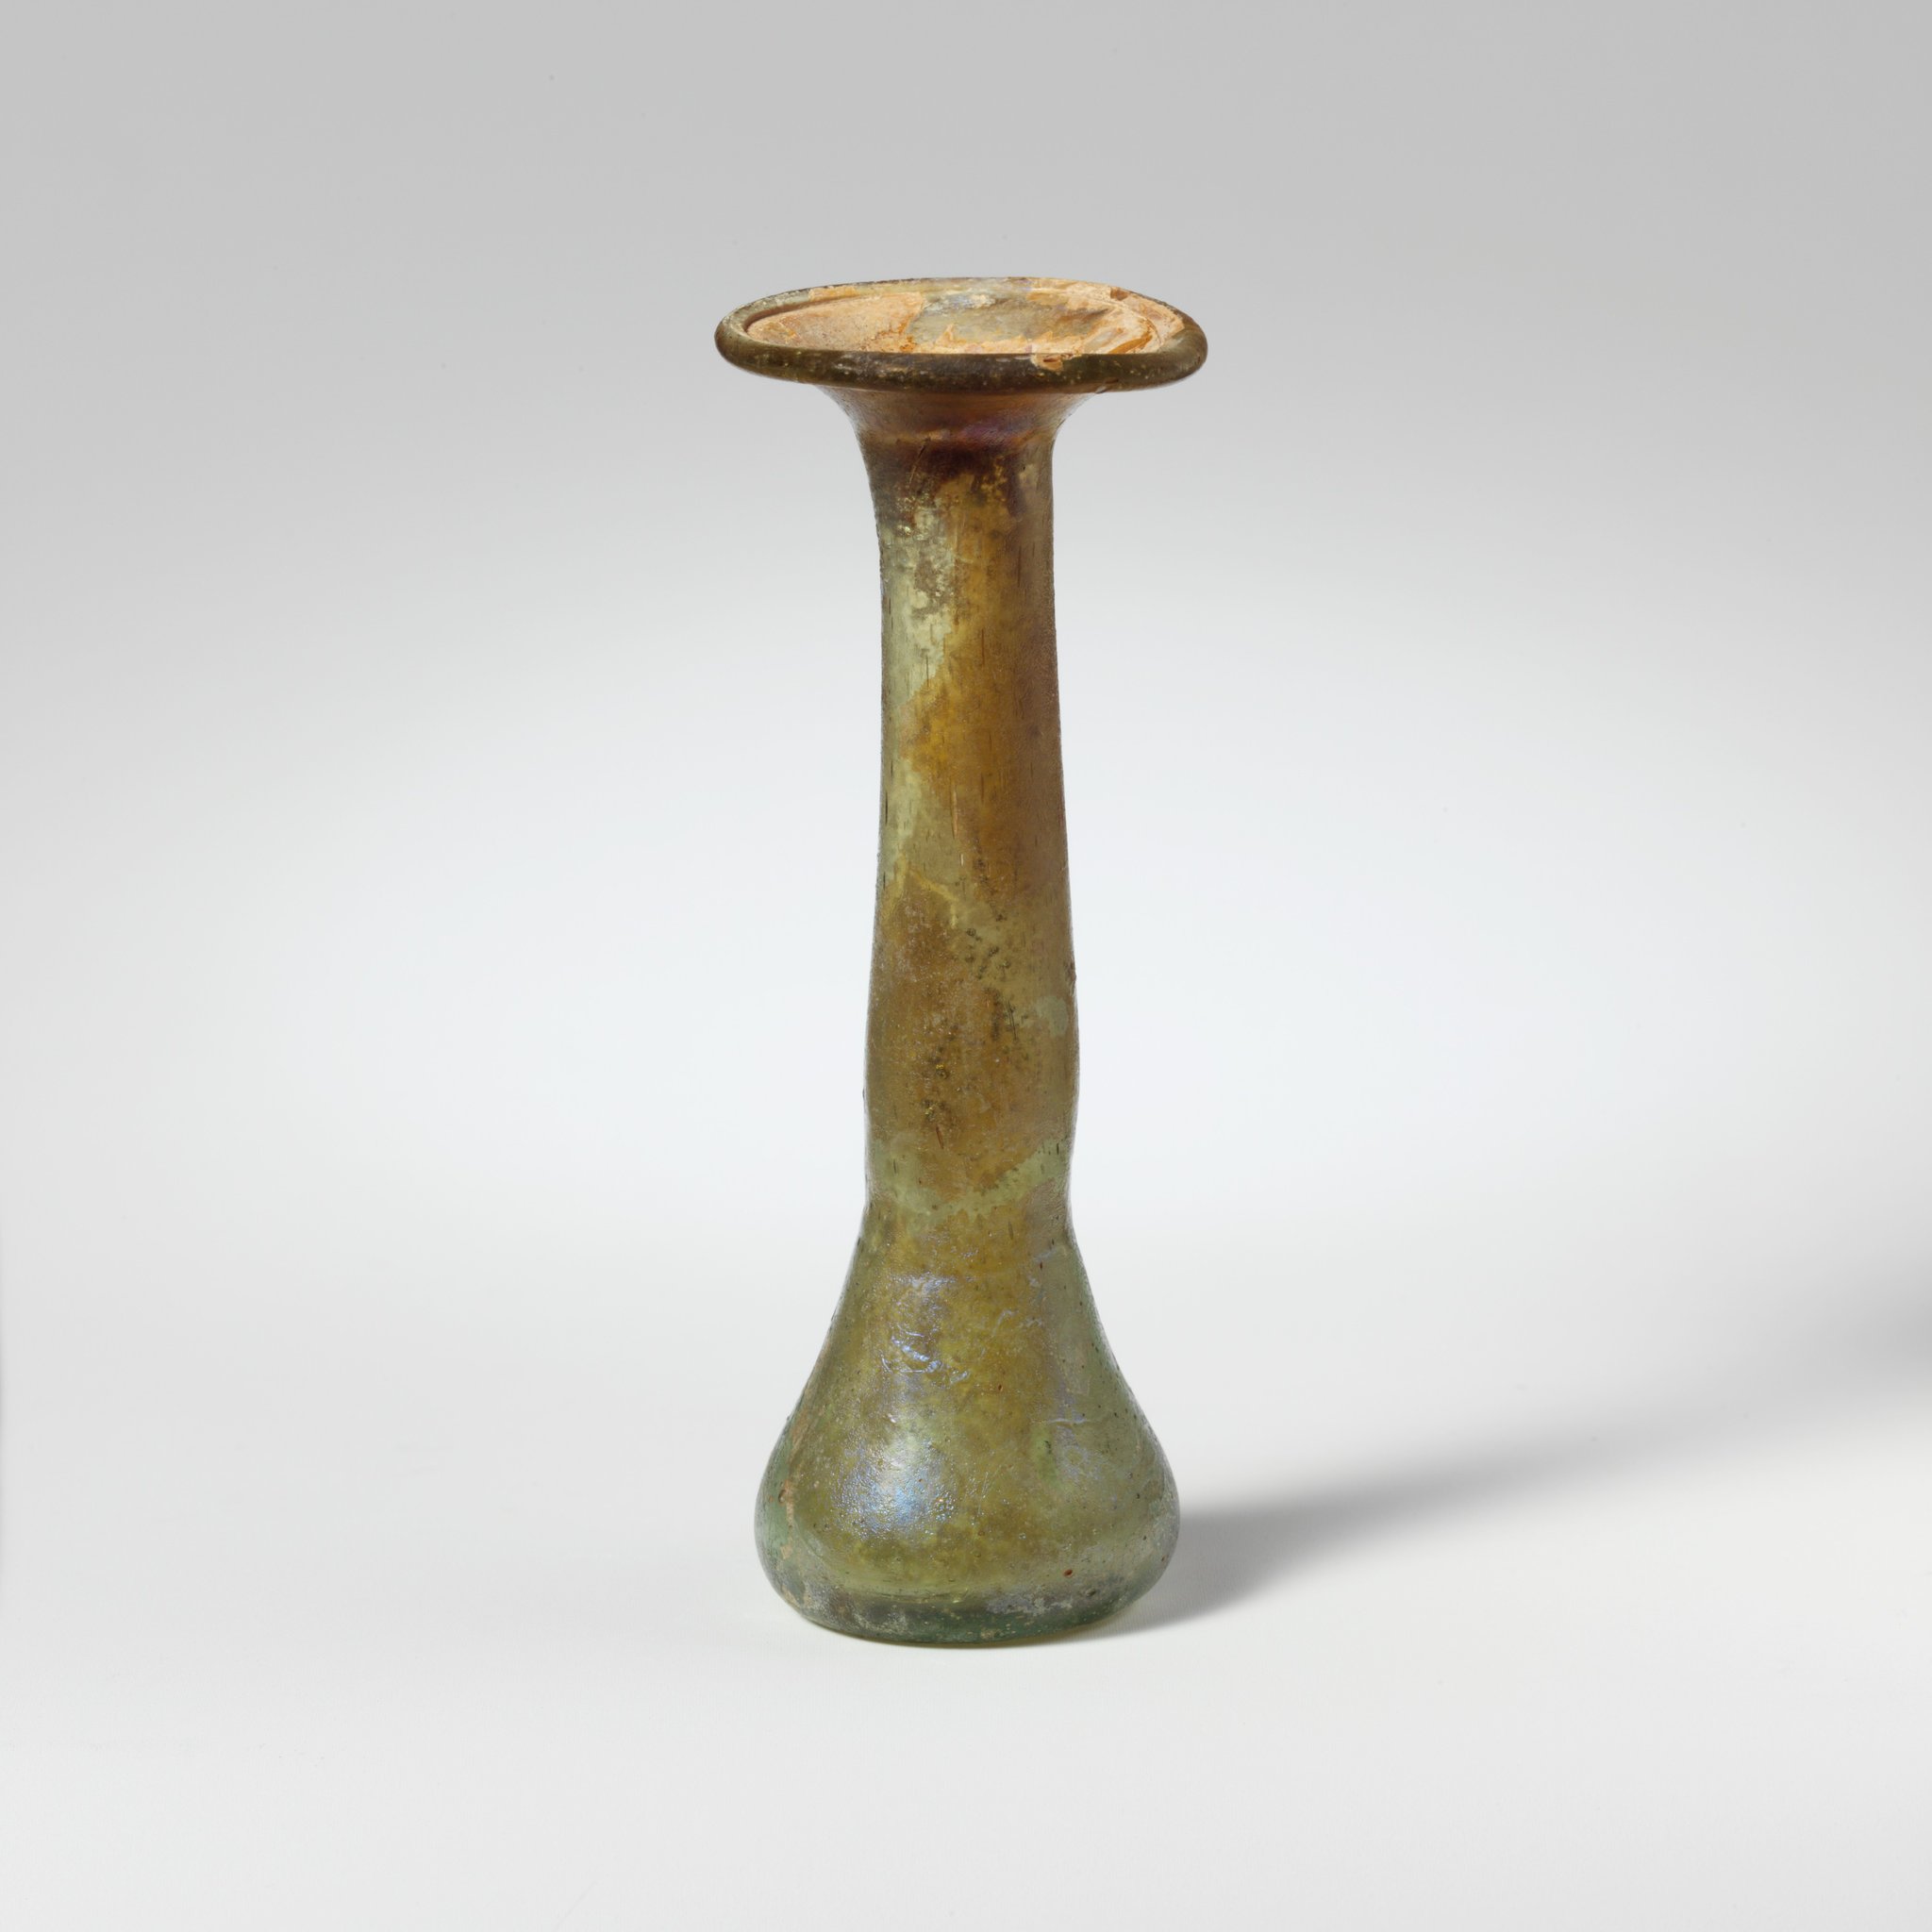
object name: perfume bottle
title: Glass perfume bottle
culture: roman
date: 1-300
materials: glass